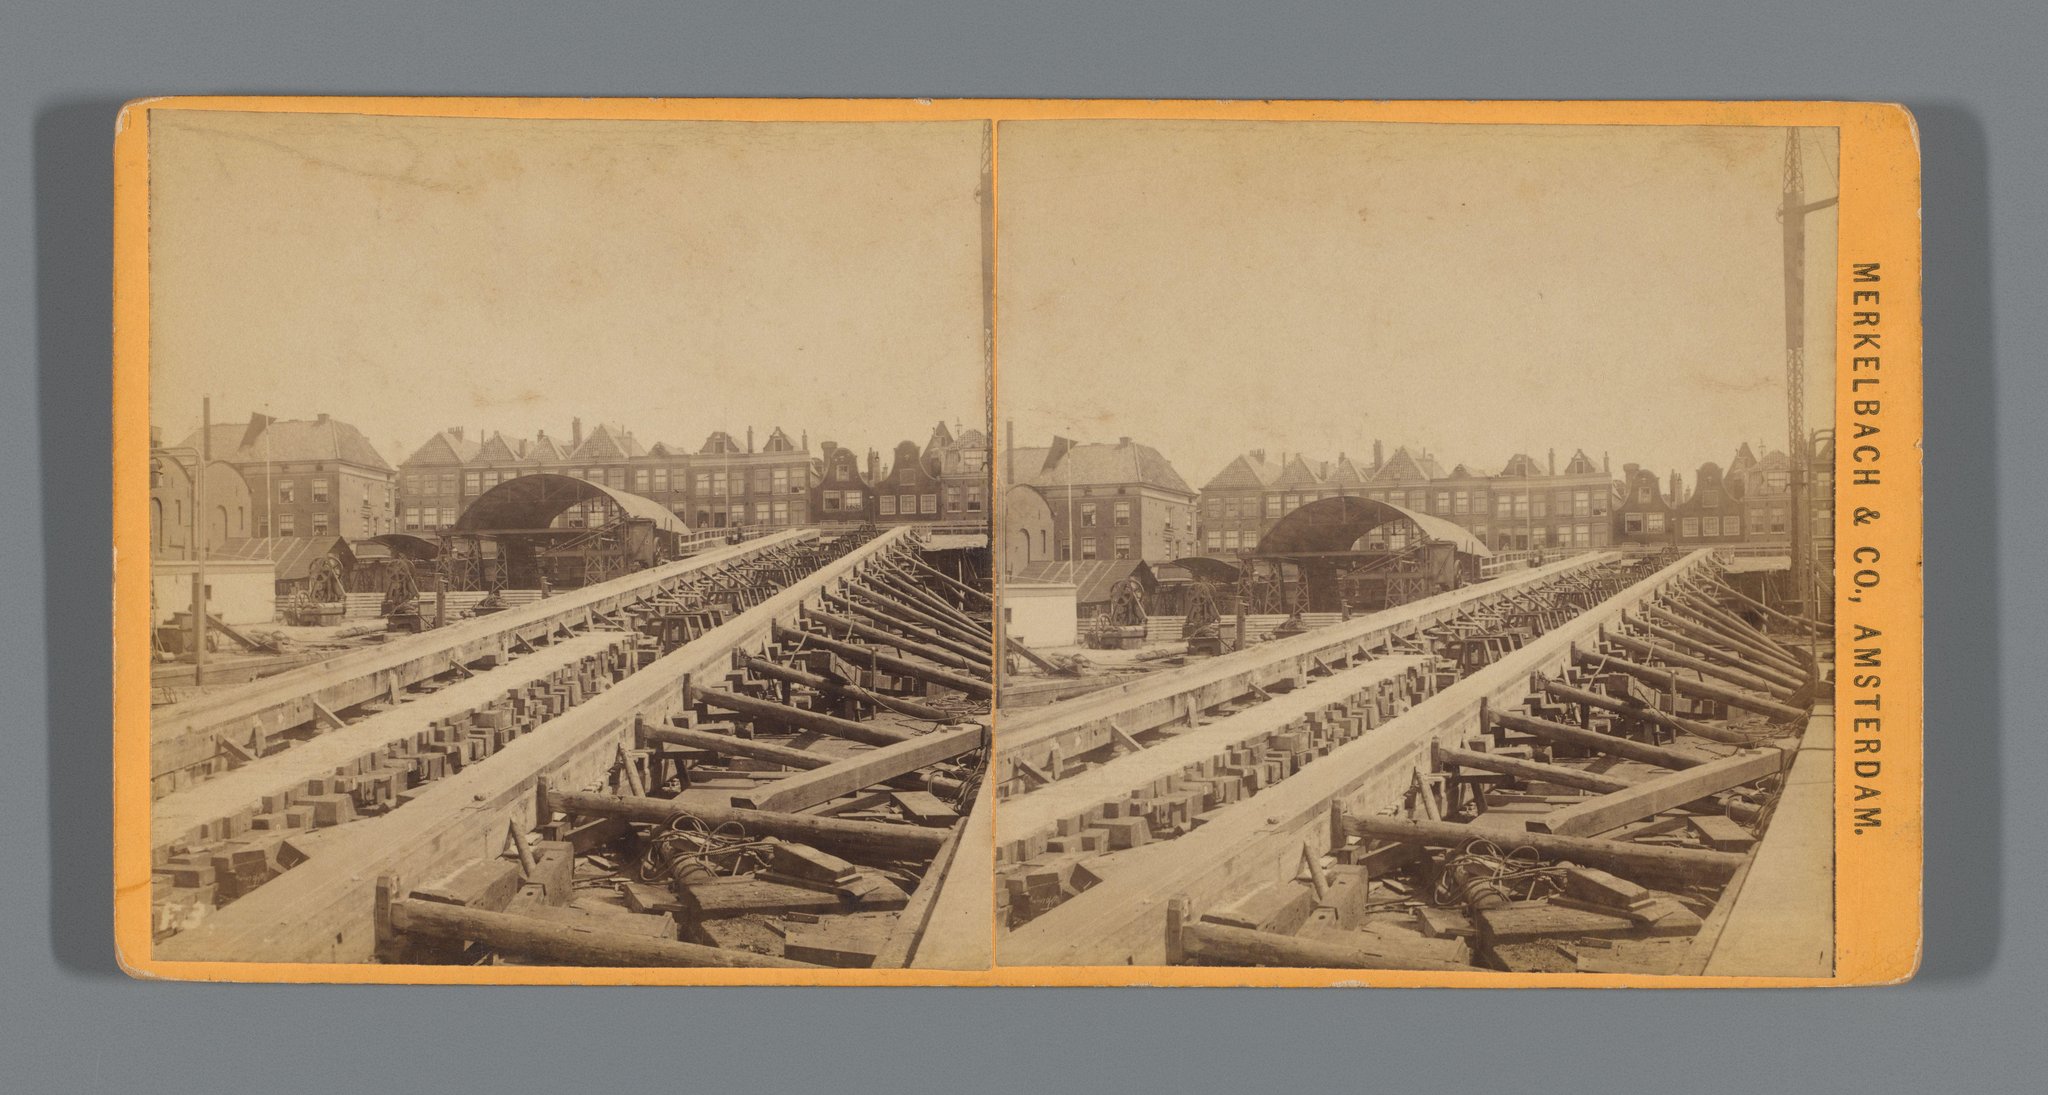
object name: stereograph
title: Aardrijkskundige Beeldengalerij, verzameld door M.J. Broekhuijsen, Hoofd eener school te Amsterdam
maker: martien johan broekhuijsen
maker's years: 1871-1956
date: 1905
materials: photographic support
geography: amsterdam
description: Onderdeel van een groep van 52 stereofoto's gebruikt in het lager onderwijs als aanvulling op schoolplaten. De gehele reeks bestond uit 274 nummers in 10 categorieën (A t/m K).